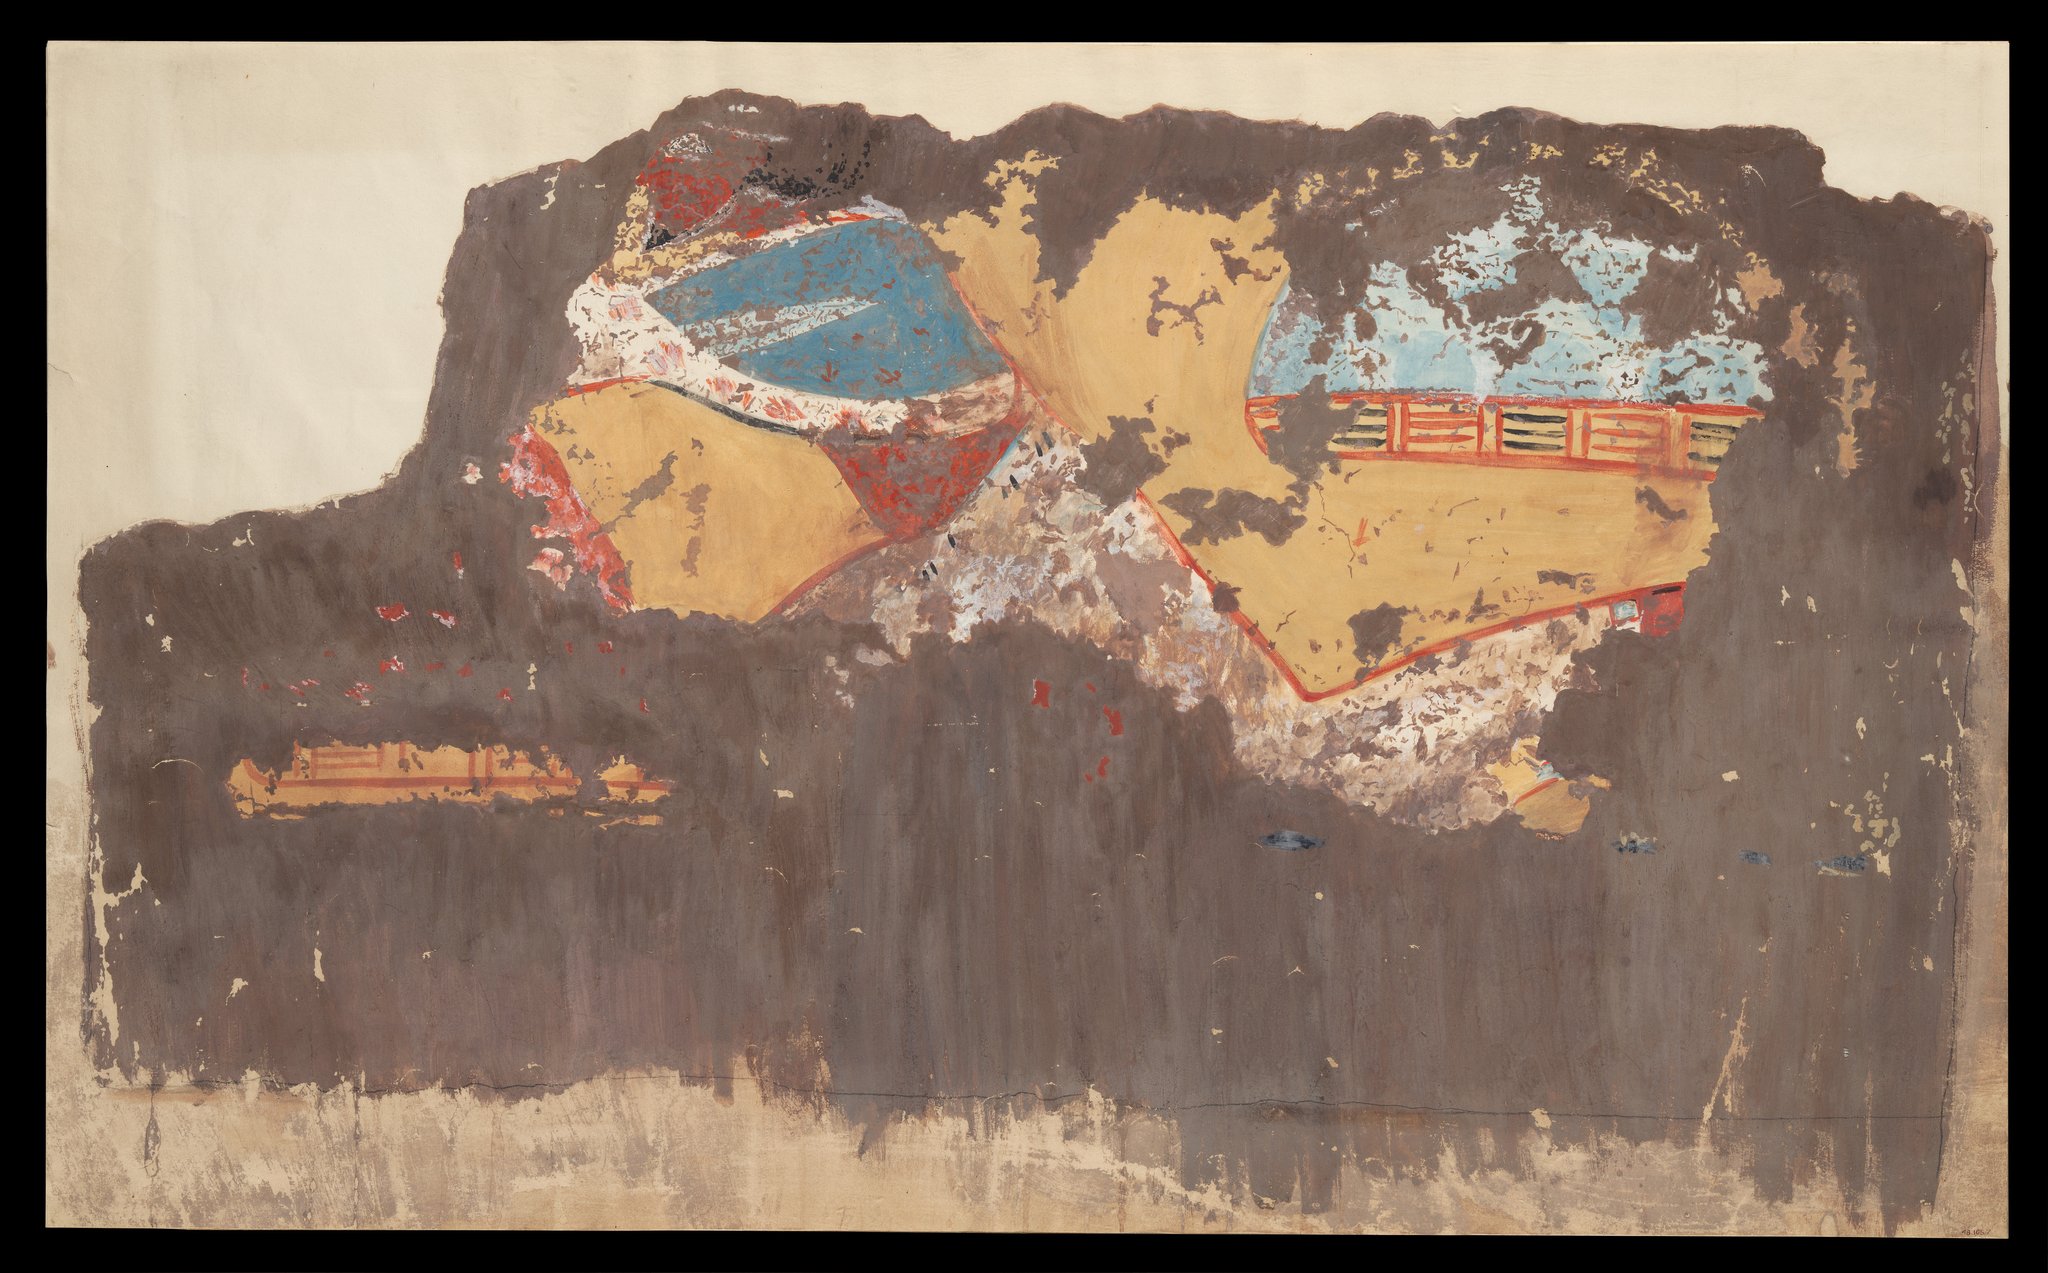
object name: facsimile, amenhotep iii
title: Syrian Kneeling to the Left, Palace of Amenhotep III at Malqata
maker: william j. palmer-jones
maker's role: artist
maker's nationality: british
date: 1390-1353 BCE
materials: paper, paint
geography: egypt